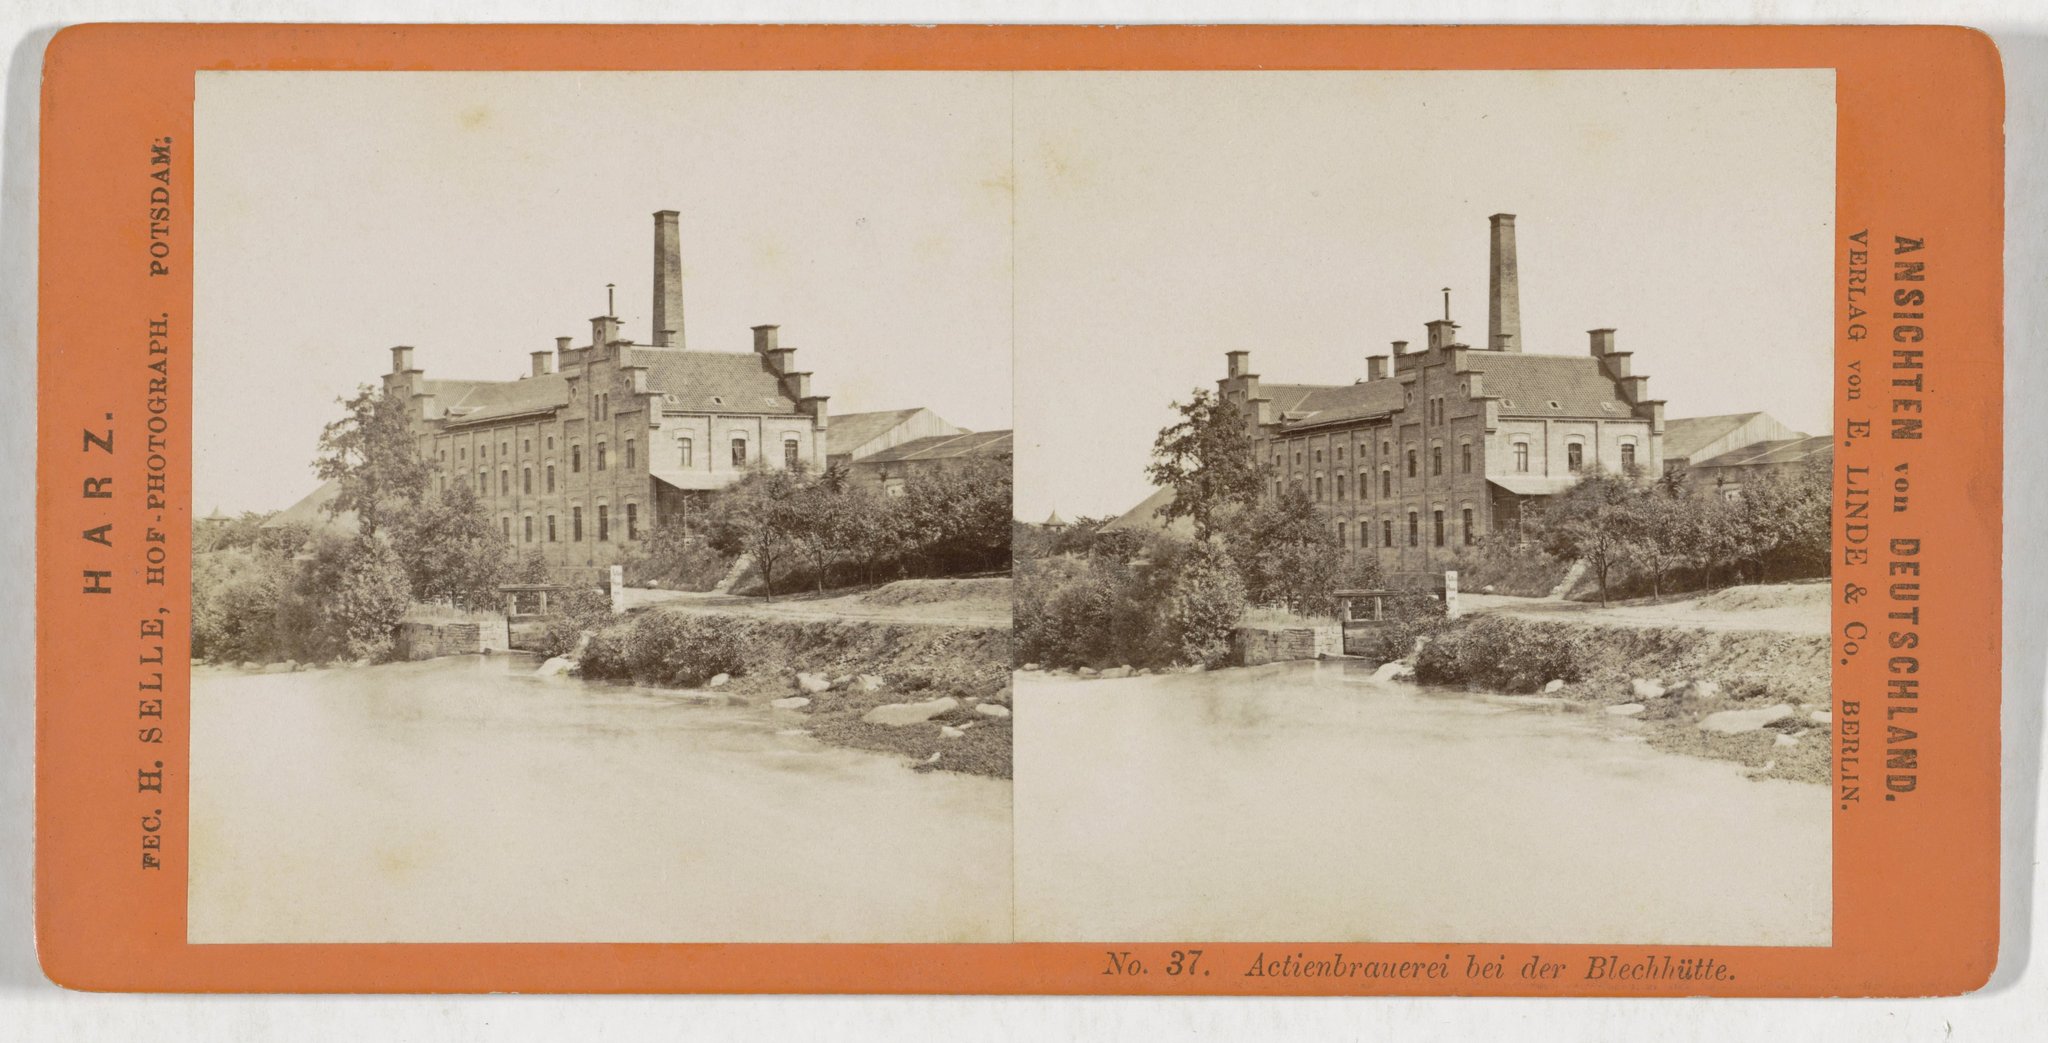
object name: stereograph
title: Actienbrauerei bei der Blechhütte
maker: hermann selle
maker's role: fotograaf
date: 1868-1890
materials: cardboard, paper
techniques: albumen print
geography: thale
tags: brewer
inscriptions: inscription: ‘Hof-Photograph. Potsdam’, number: ‘No. 37.’